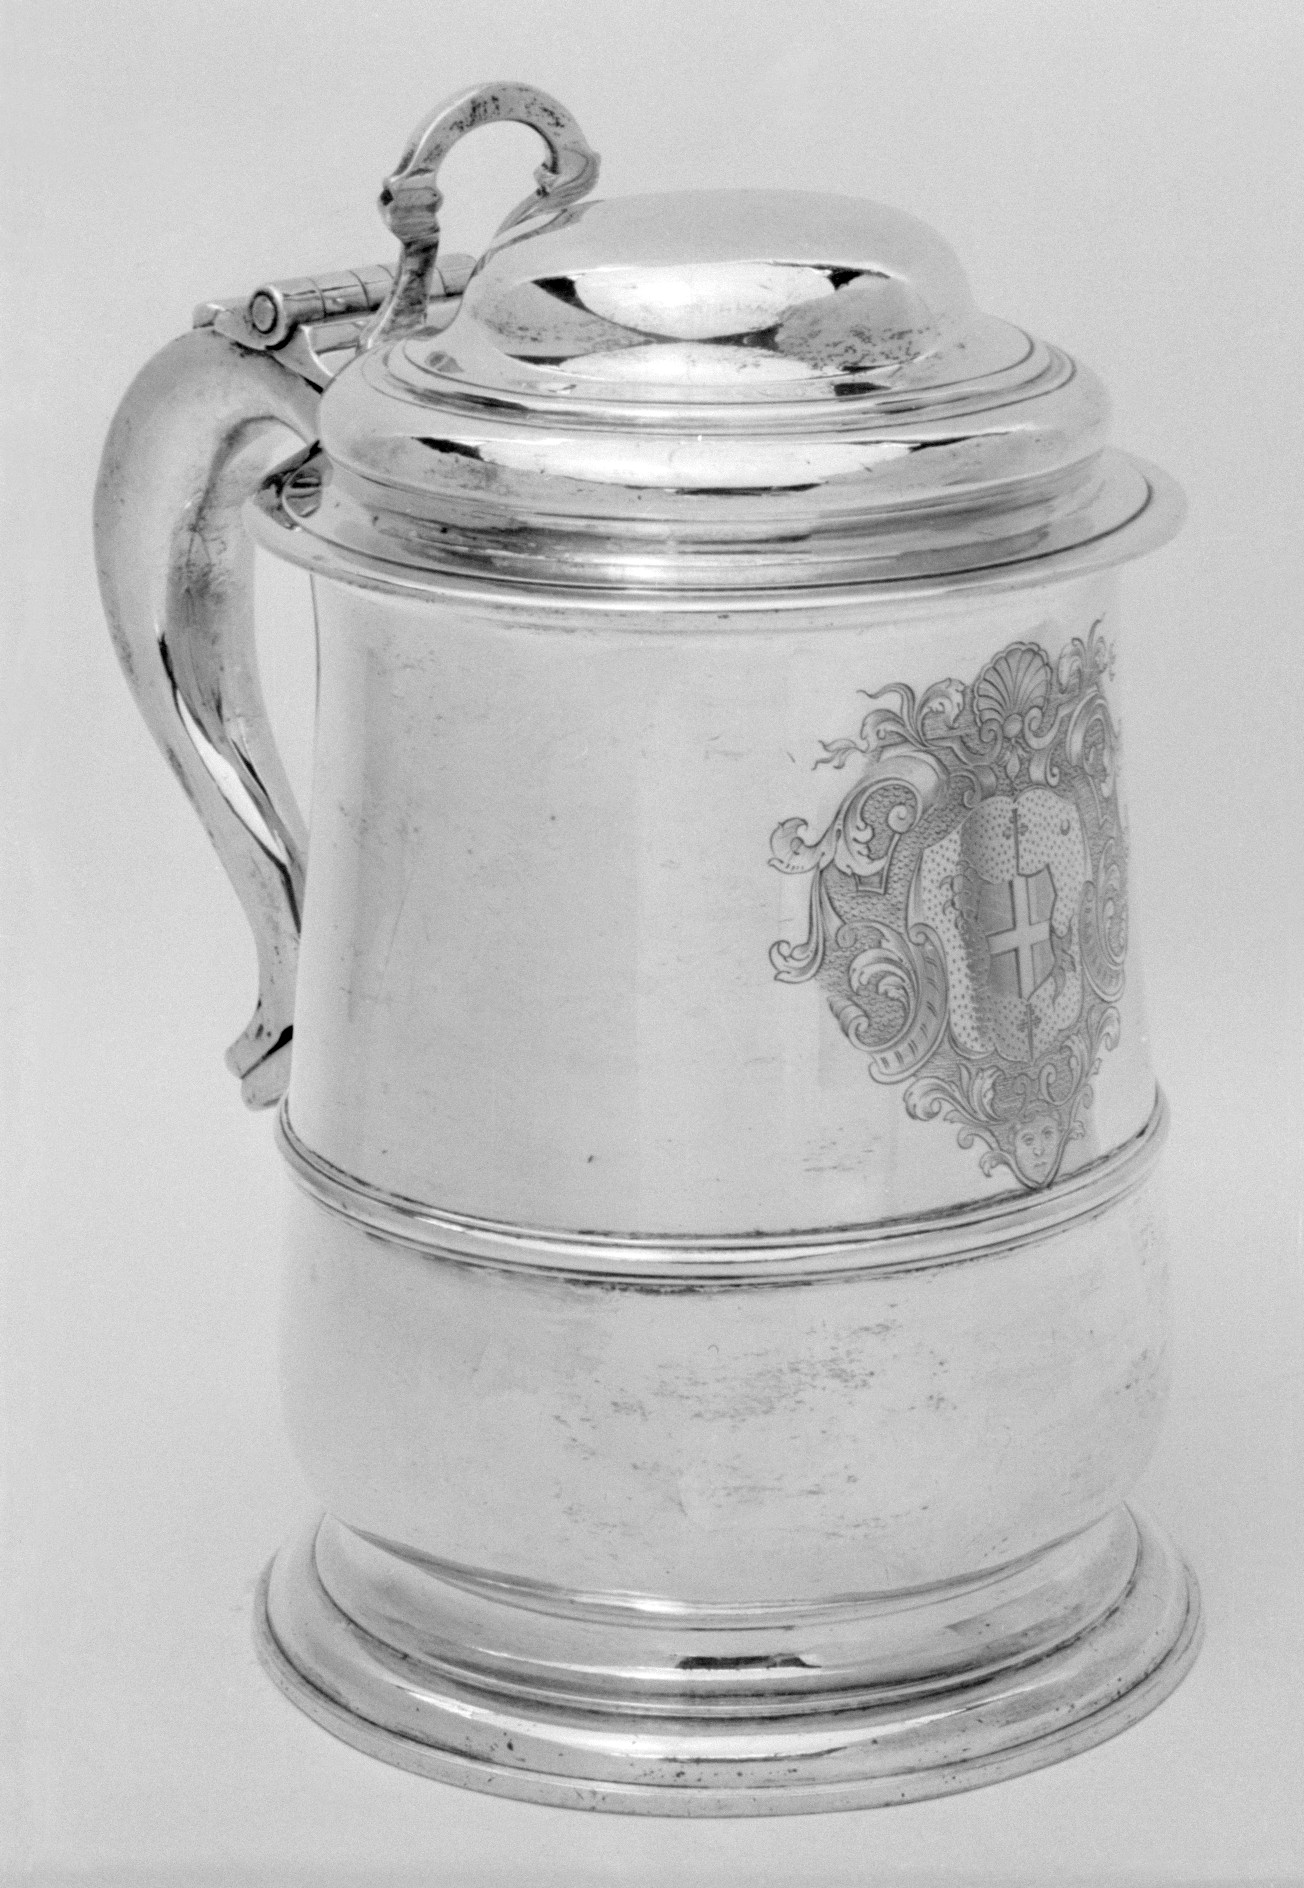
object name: tankard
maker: edward pocock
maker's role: maker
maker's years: 1728-1734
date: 1735-1736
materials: silver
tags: coat of arms